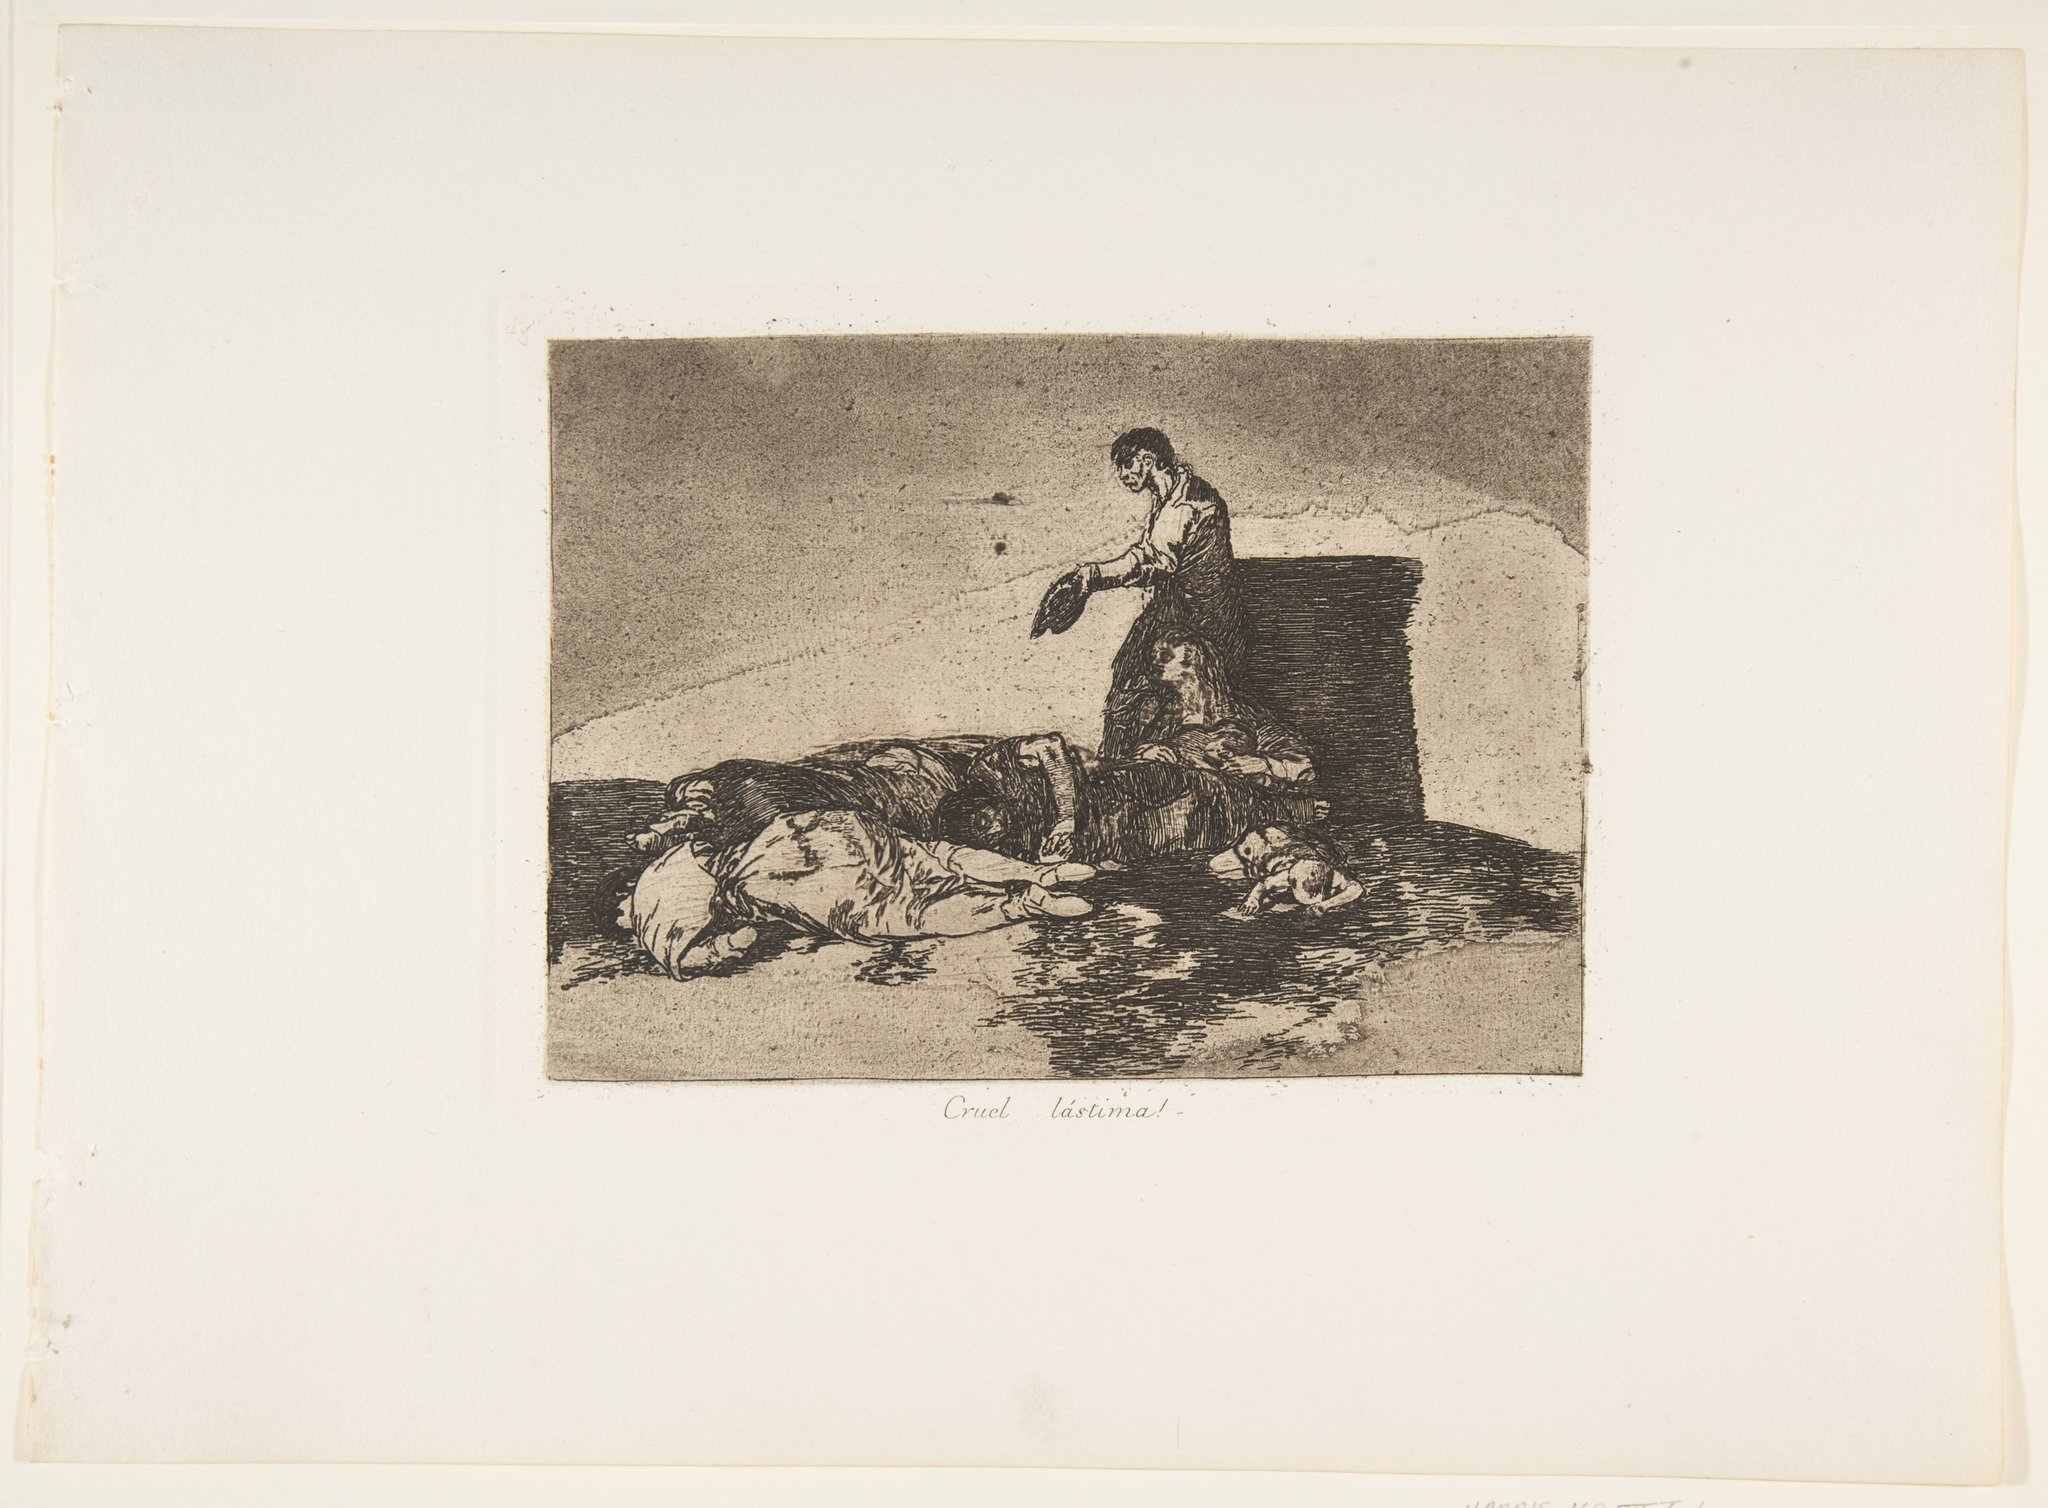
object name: print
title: Plate 48 from "The Disasters of War" (Los Desastres de la Guerra): Cruel tale of woe! (Cruel Lástima!)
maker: goya (francisco de goya y lucientes)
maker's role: artist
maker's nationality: spanish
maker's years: 1746-1828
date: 1811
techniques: engraving, burnishing, etching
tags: corpses,men